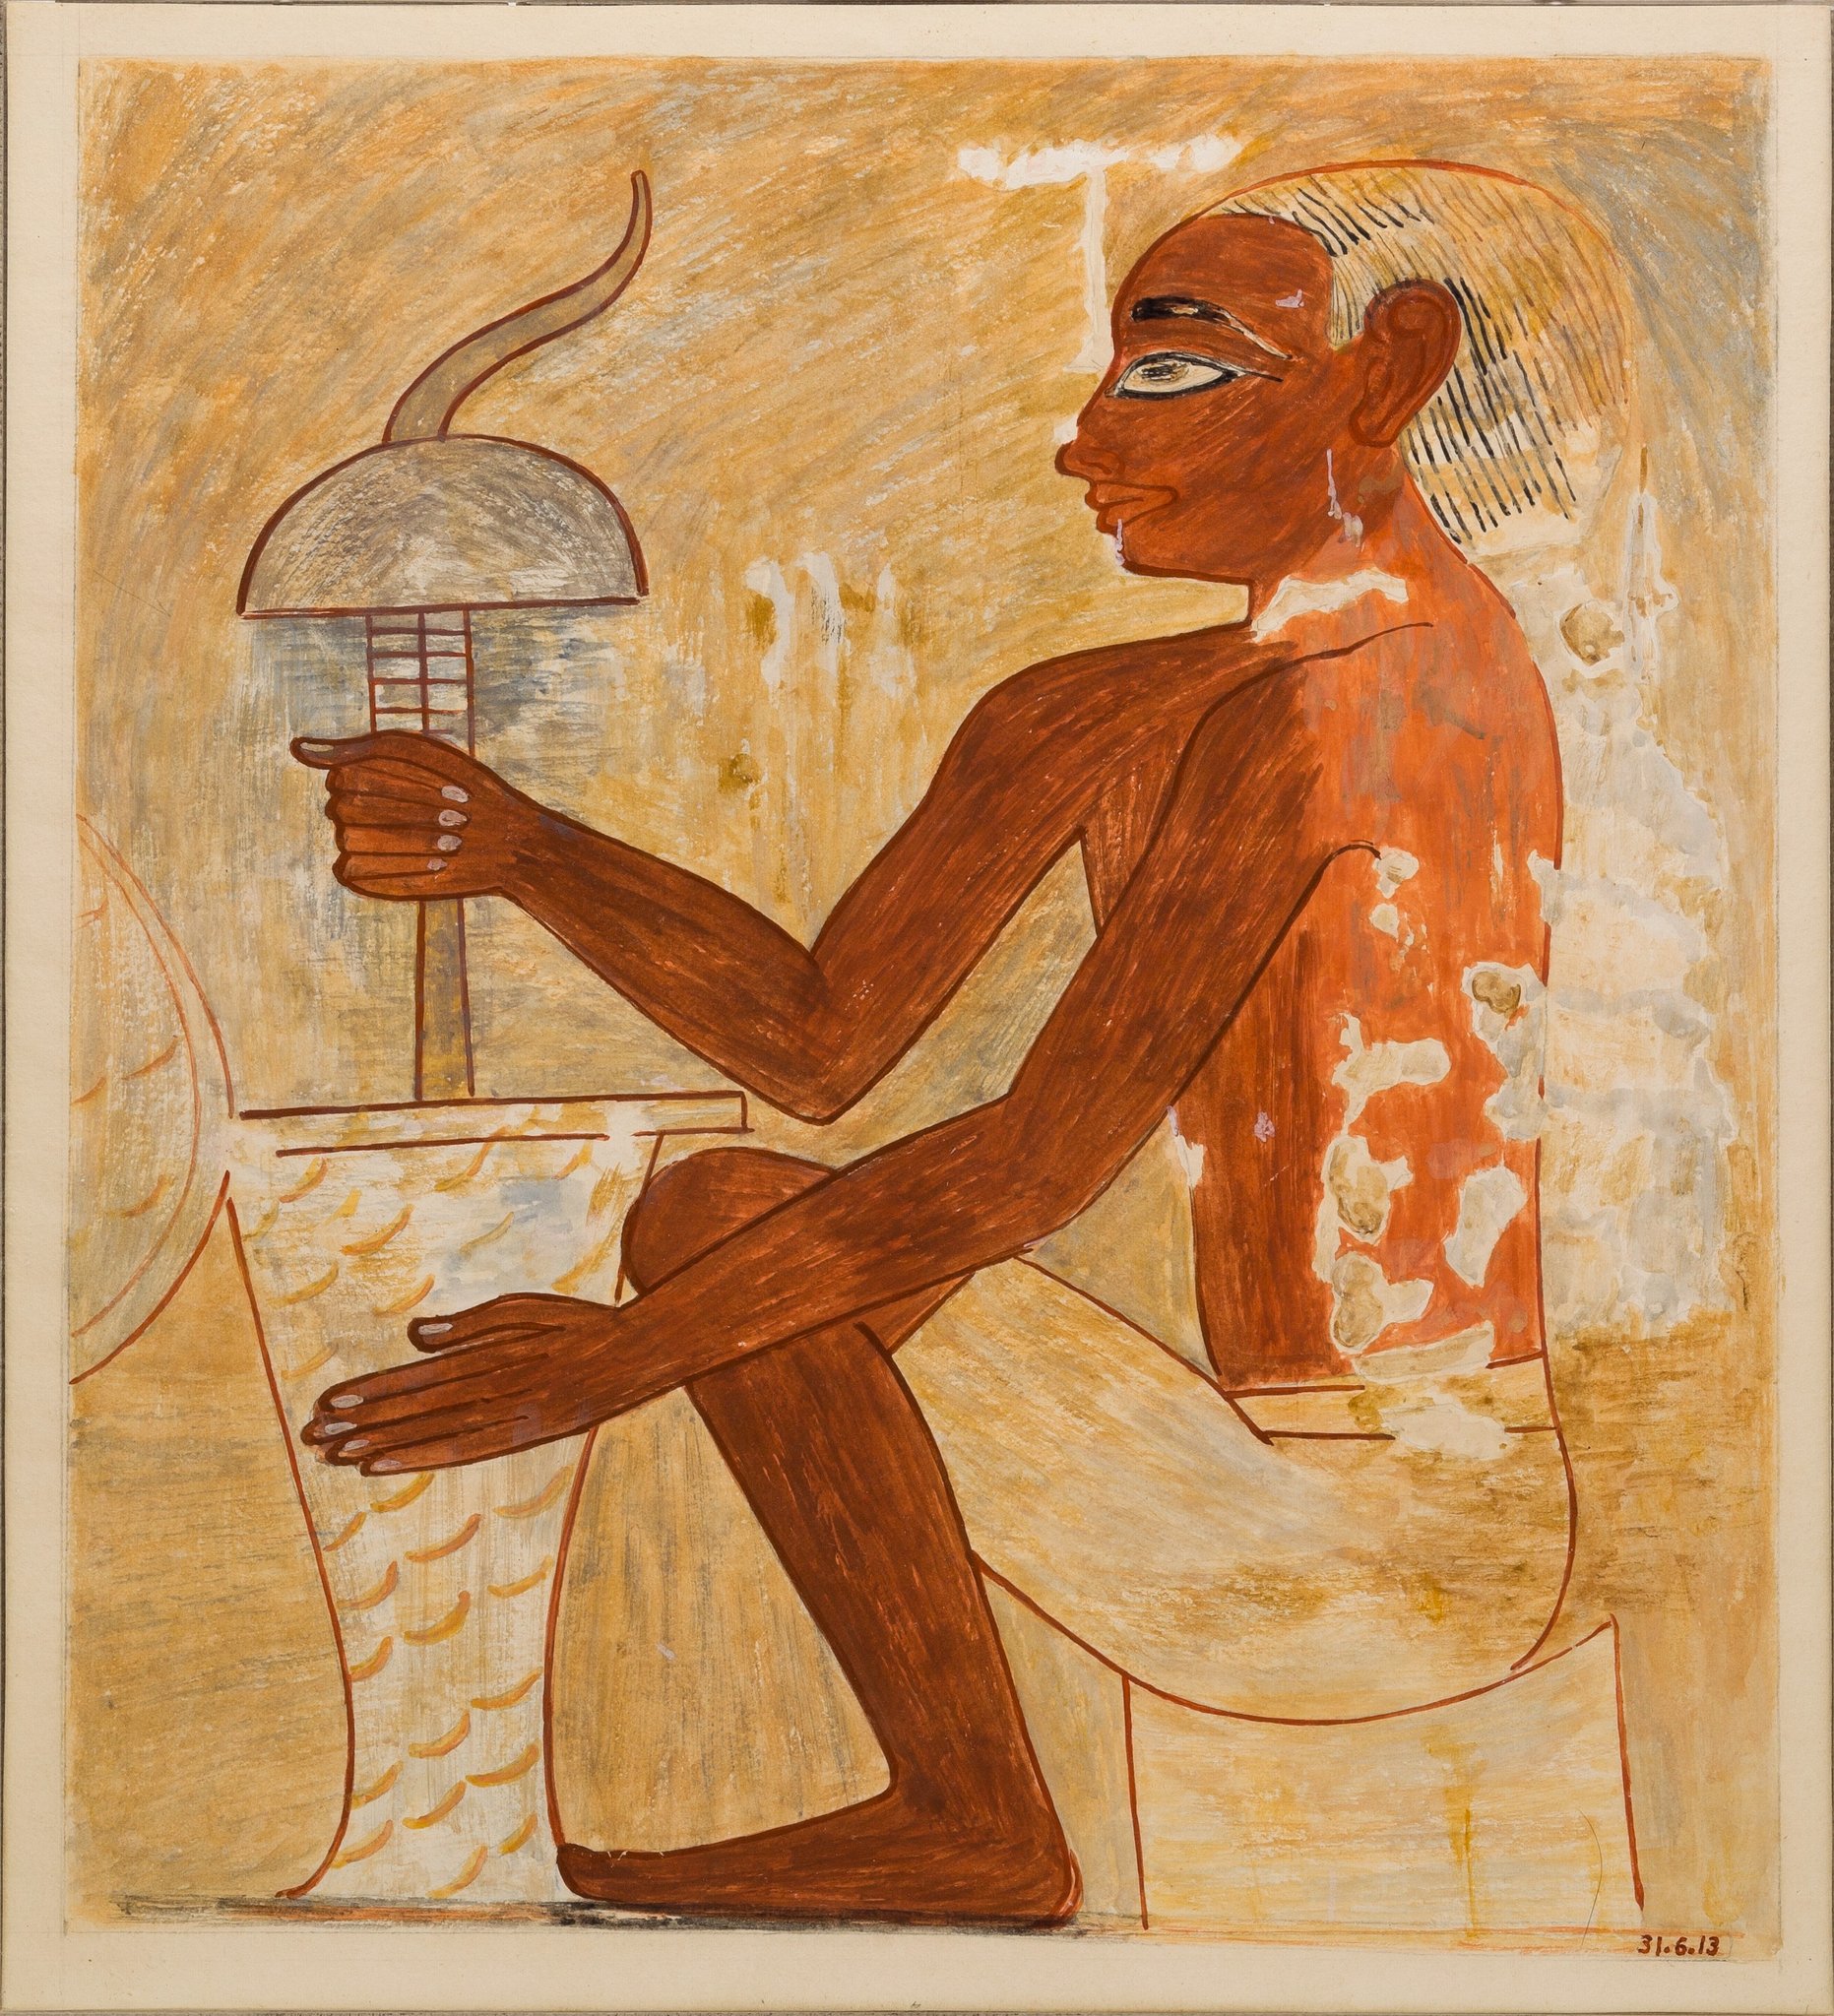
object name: facsimile, rekhmire tt 100, drilling stone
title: Drilling a Stone Vase, Tomb of Rekhmire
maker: nina de garis davies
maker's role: artist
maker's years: 1881-1965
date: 1504-1425 BCE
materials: ink, paint, paper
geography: egypt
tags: men,working,vases,rekhmire-exhibition